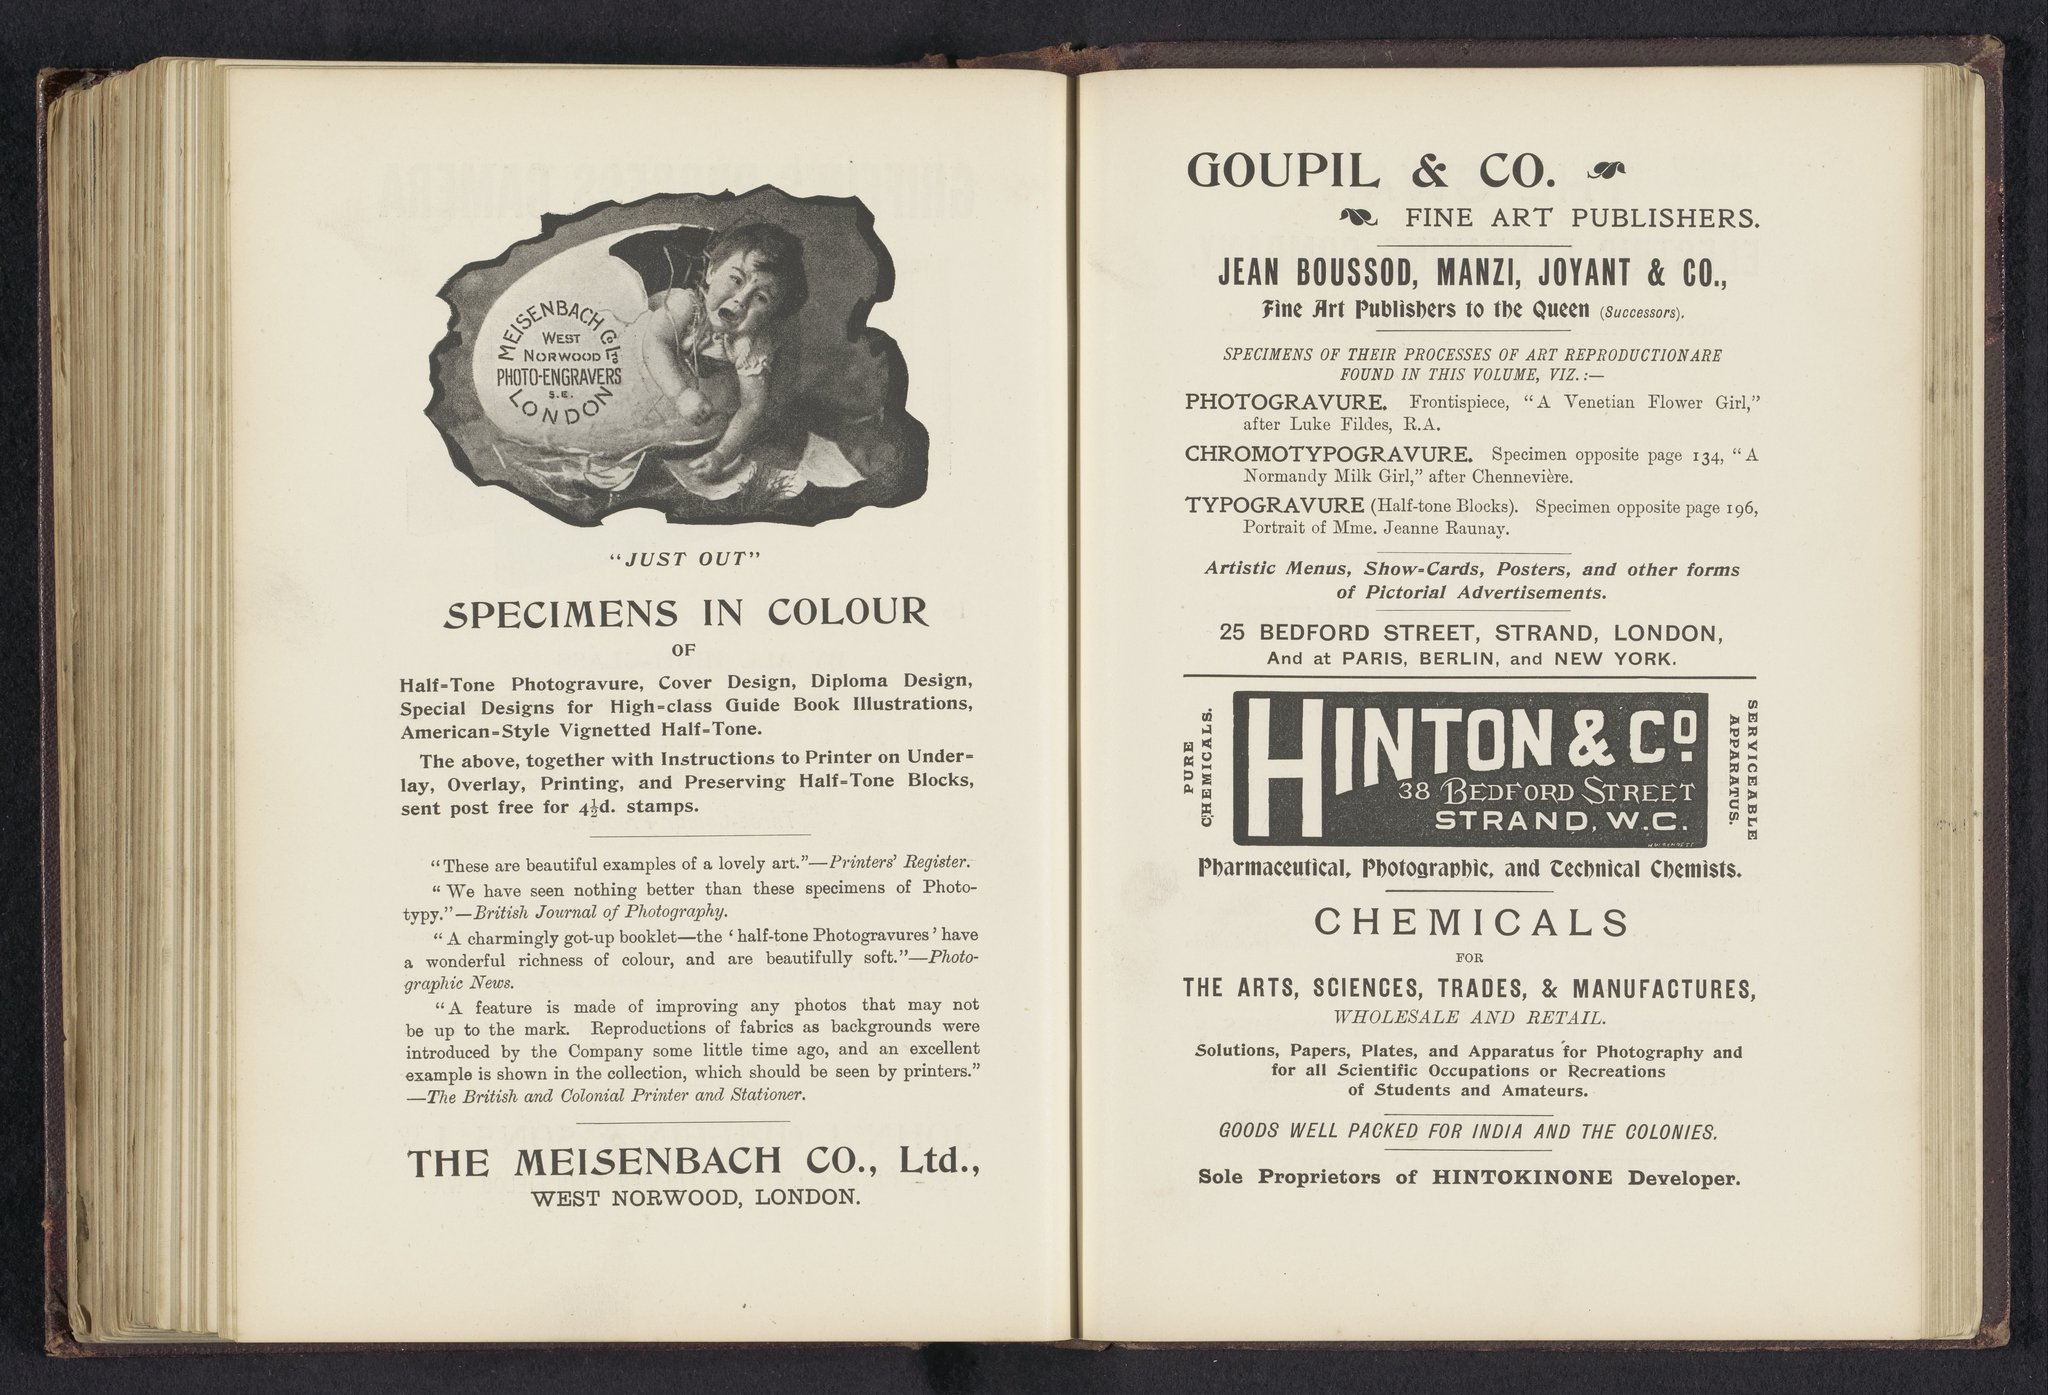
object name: photomechanical print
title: Reclamebeeld voor The Meisenbach Company, voorstellende een huilend kind kruipt uit een ei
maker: Anonymous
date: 1889-1899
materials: paper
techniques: autotype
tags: child, eggs, egg-dishes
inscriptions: inscription: ‘"Just out" (...) West Norwood, London.’